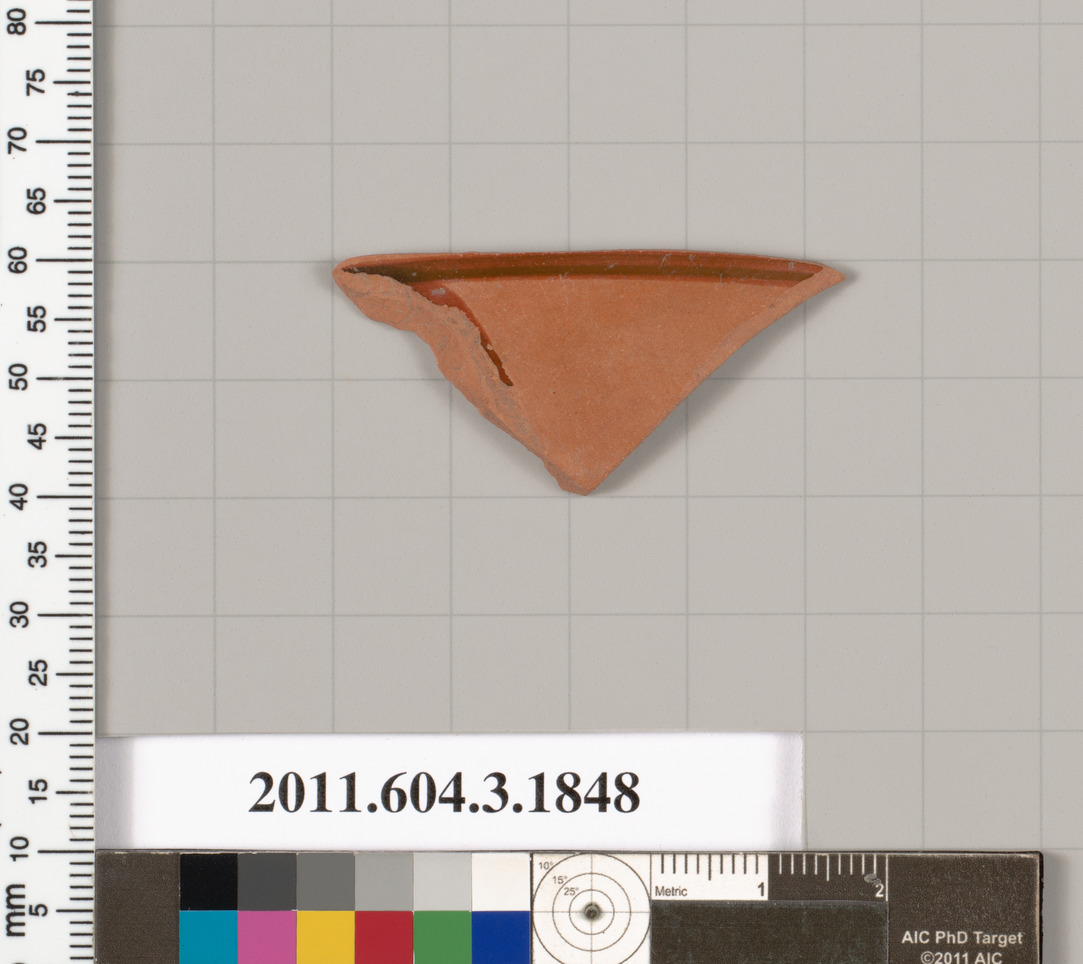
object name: kylix fragment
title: Terracotta fragment of a kylix: Lip cup (drinking cup)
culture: greek, attic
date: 560-525 BCE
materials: terracotta